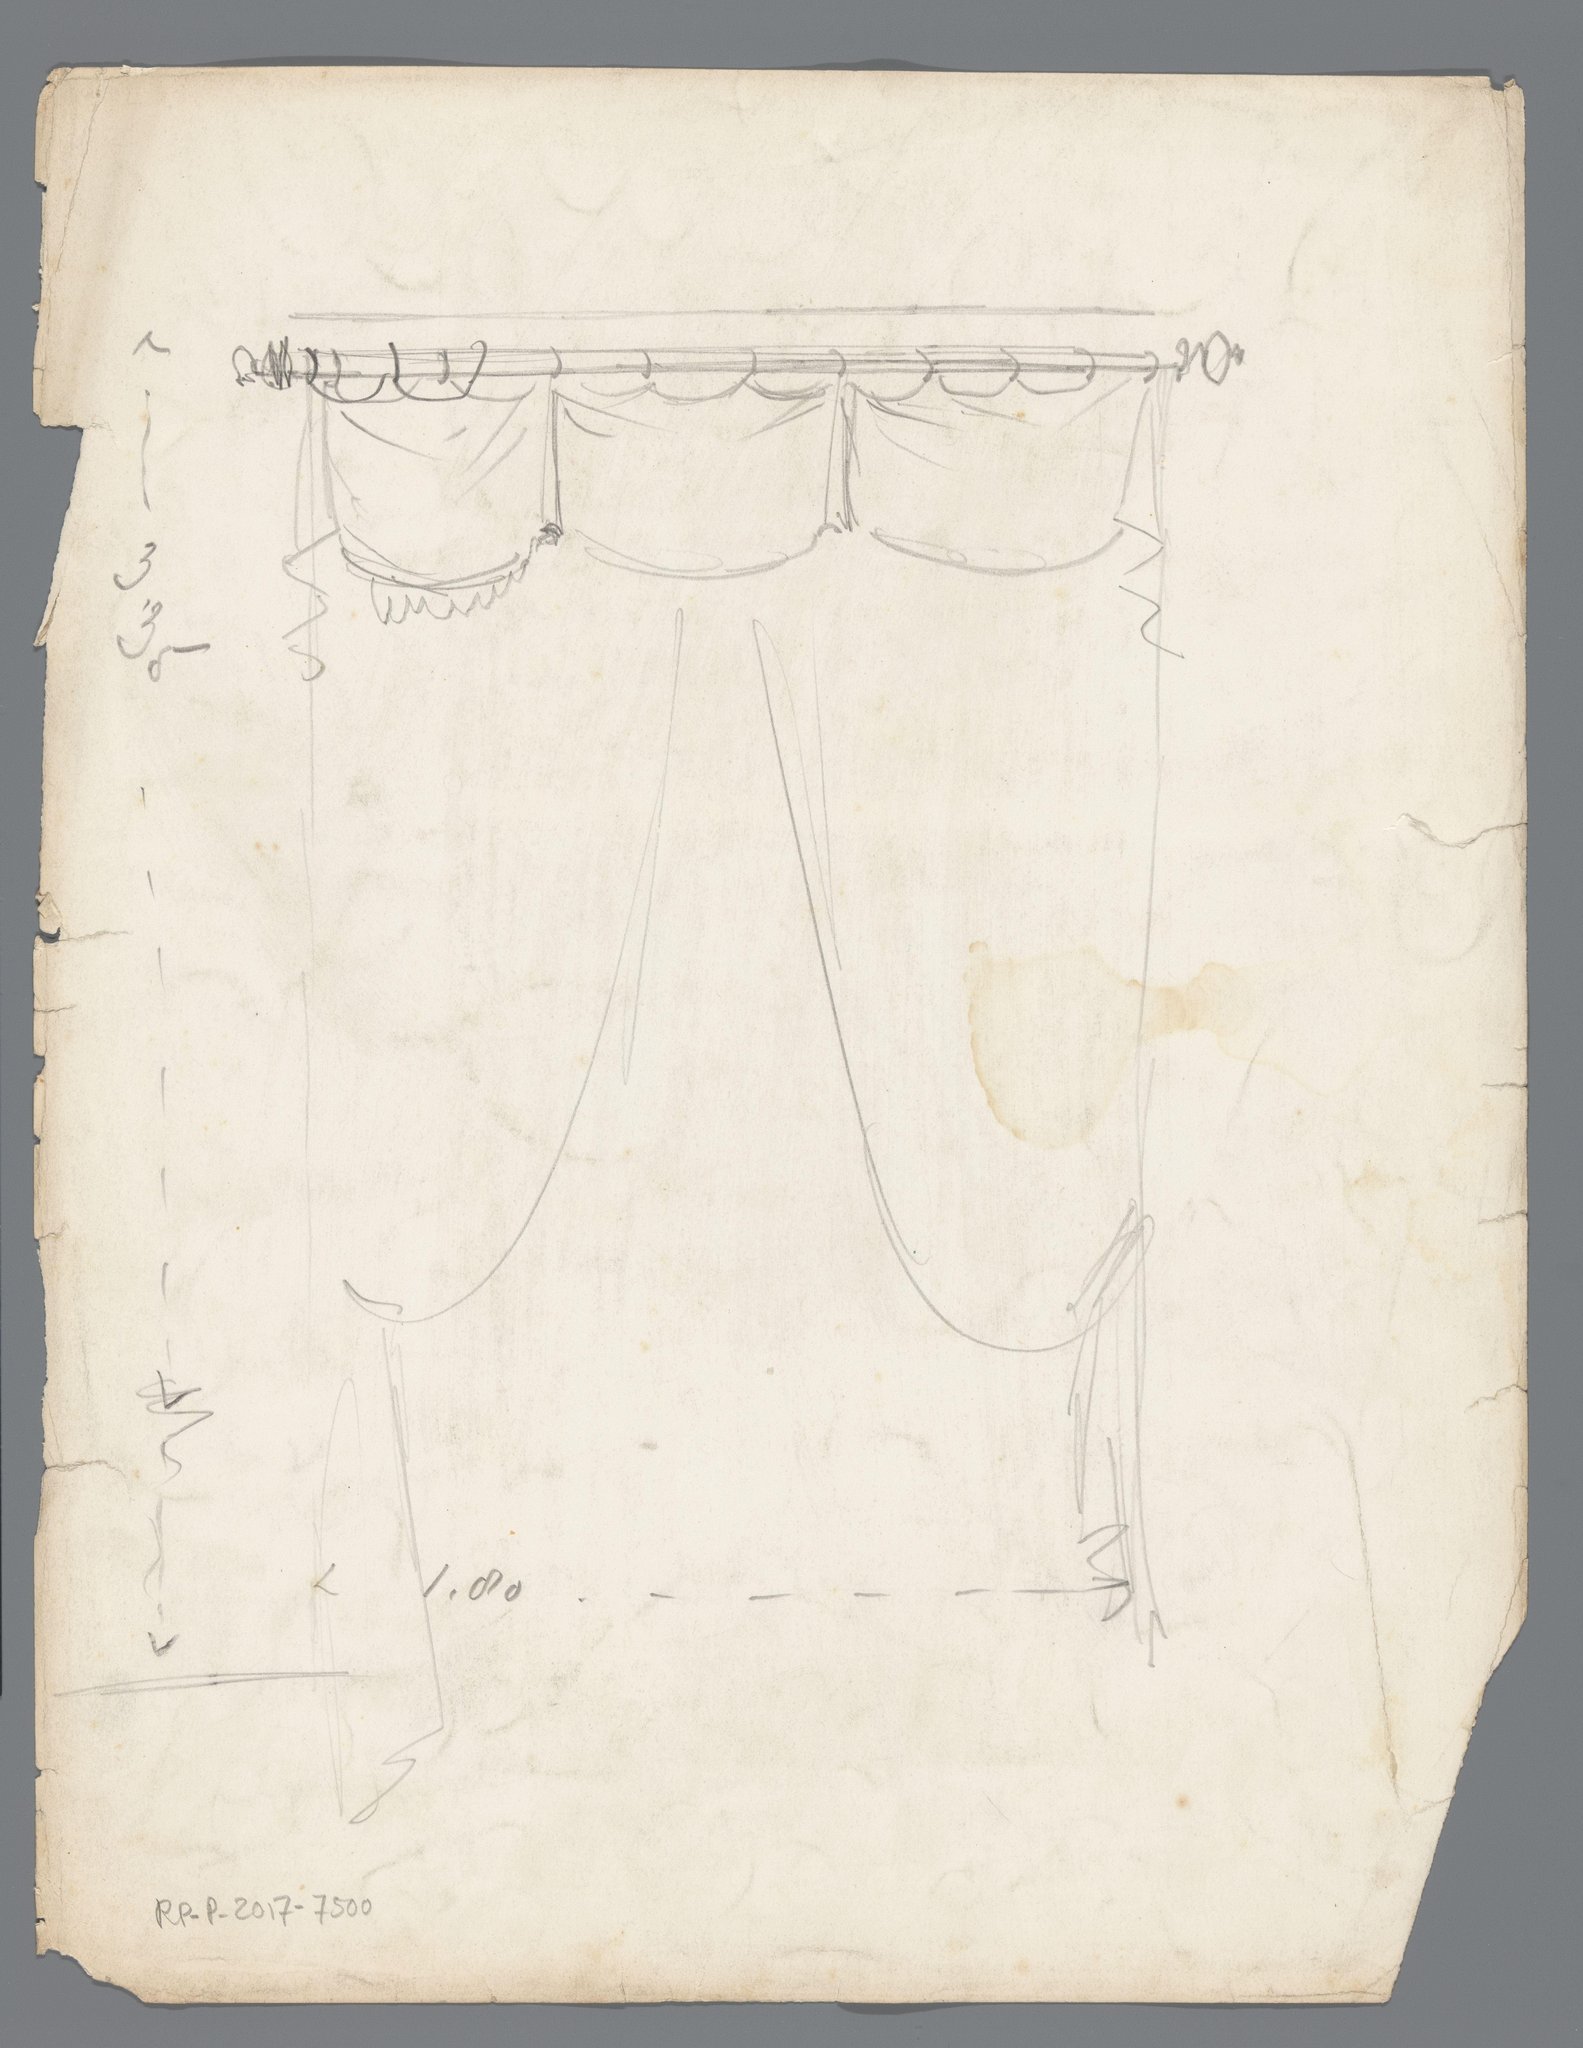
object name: drawing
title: Venster met gordijnen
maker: Anonymous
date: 1886-1899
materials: paper, pencil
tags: window, hangings and drapery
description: Venster met gordijnen waarbij lengte- en breedtematen zijn aangegeven.